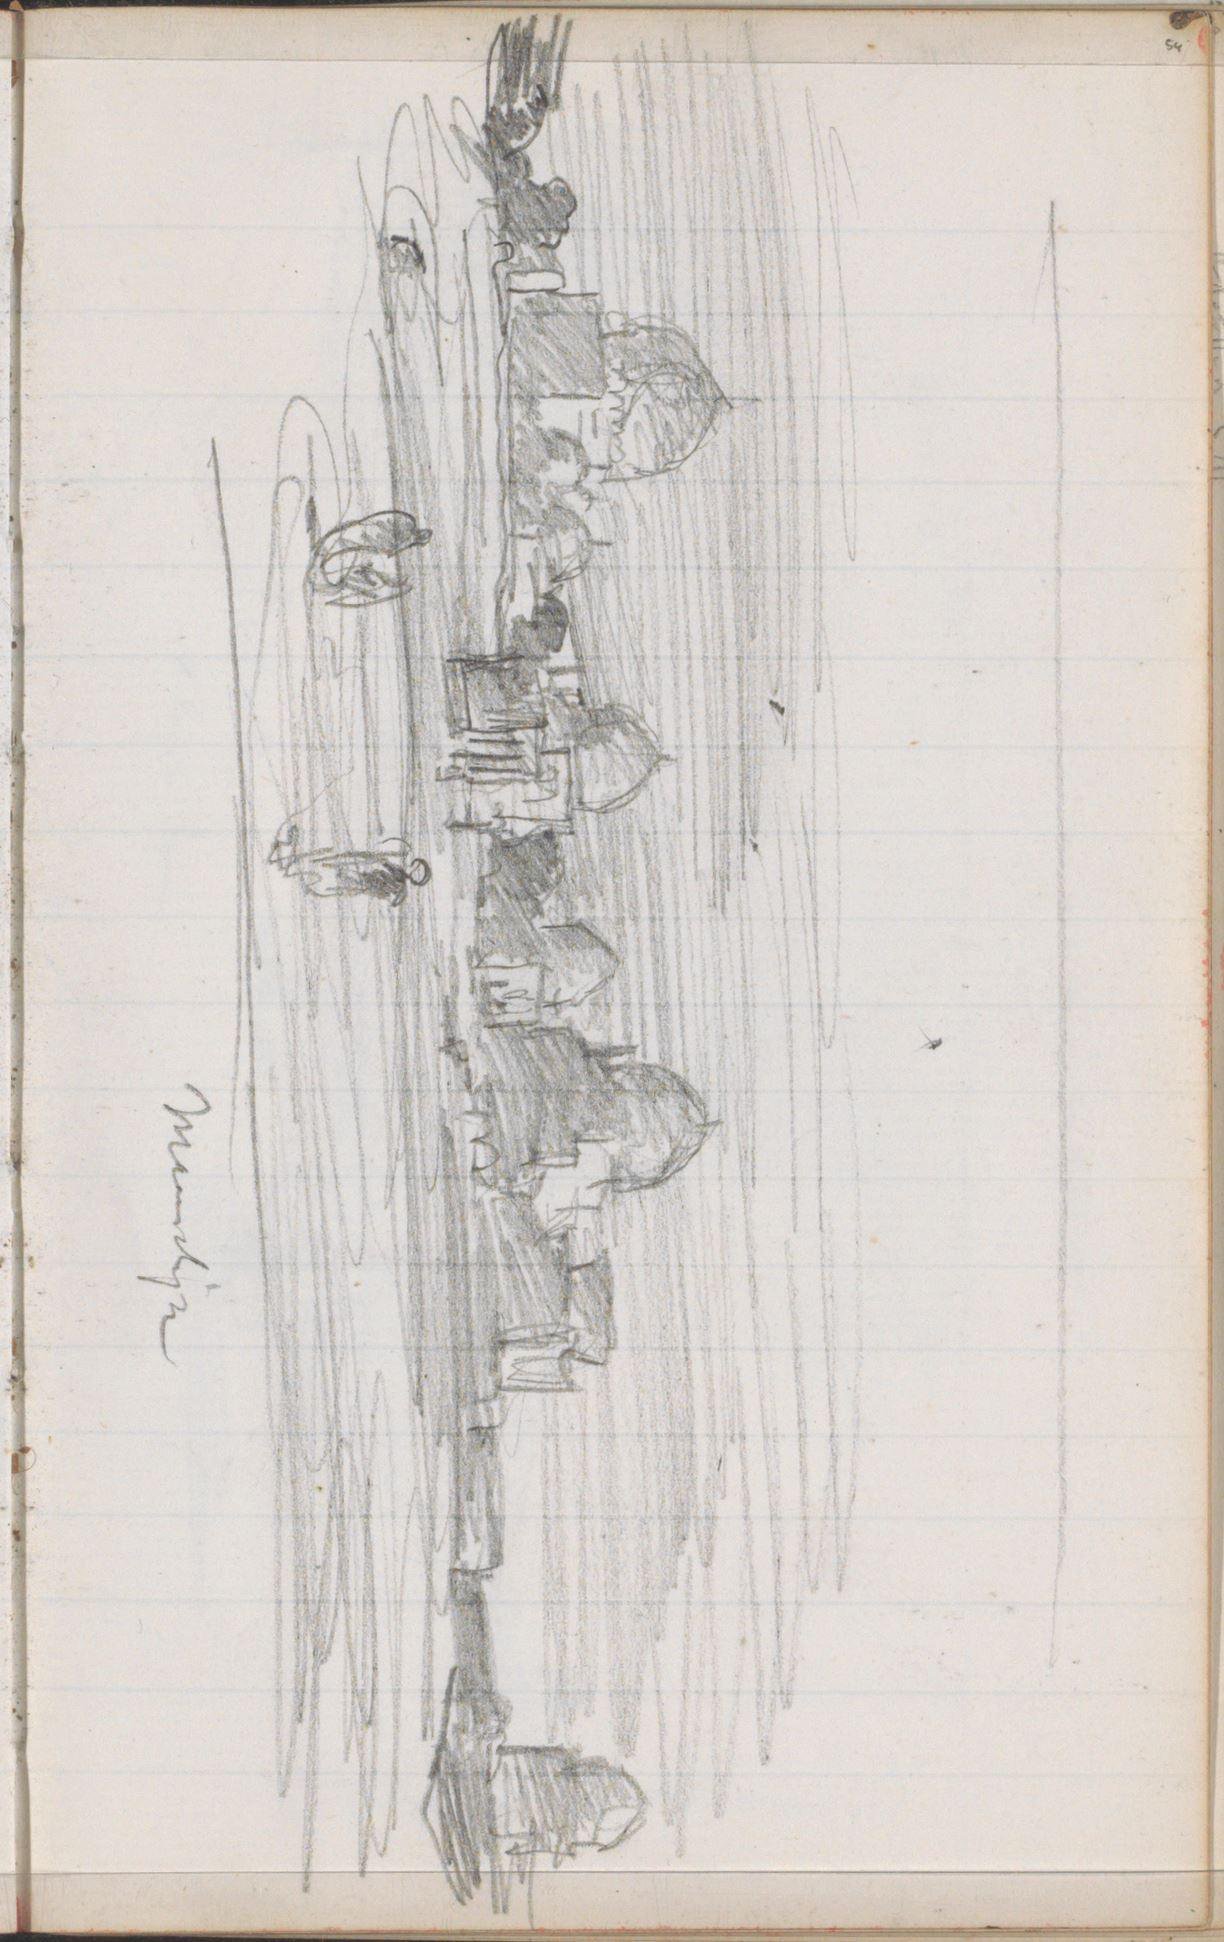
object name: sketchbook leaf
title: Landschap met gebouwen met koepeldaken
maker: marius bauer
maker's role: draughtsman, print maker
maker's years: 1867-1932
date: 1897-1898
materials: pencil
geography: india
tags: landscapes, architecture, dome ~ architecture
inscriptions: annotation: ‘maneschijn’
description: Op de voorgrond enkele figuren. Pagina 54 uit een schetsboek met 62 bladen.